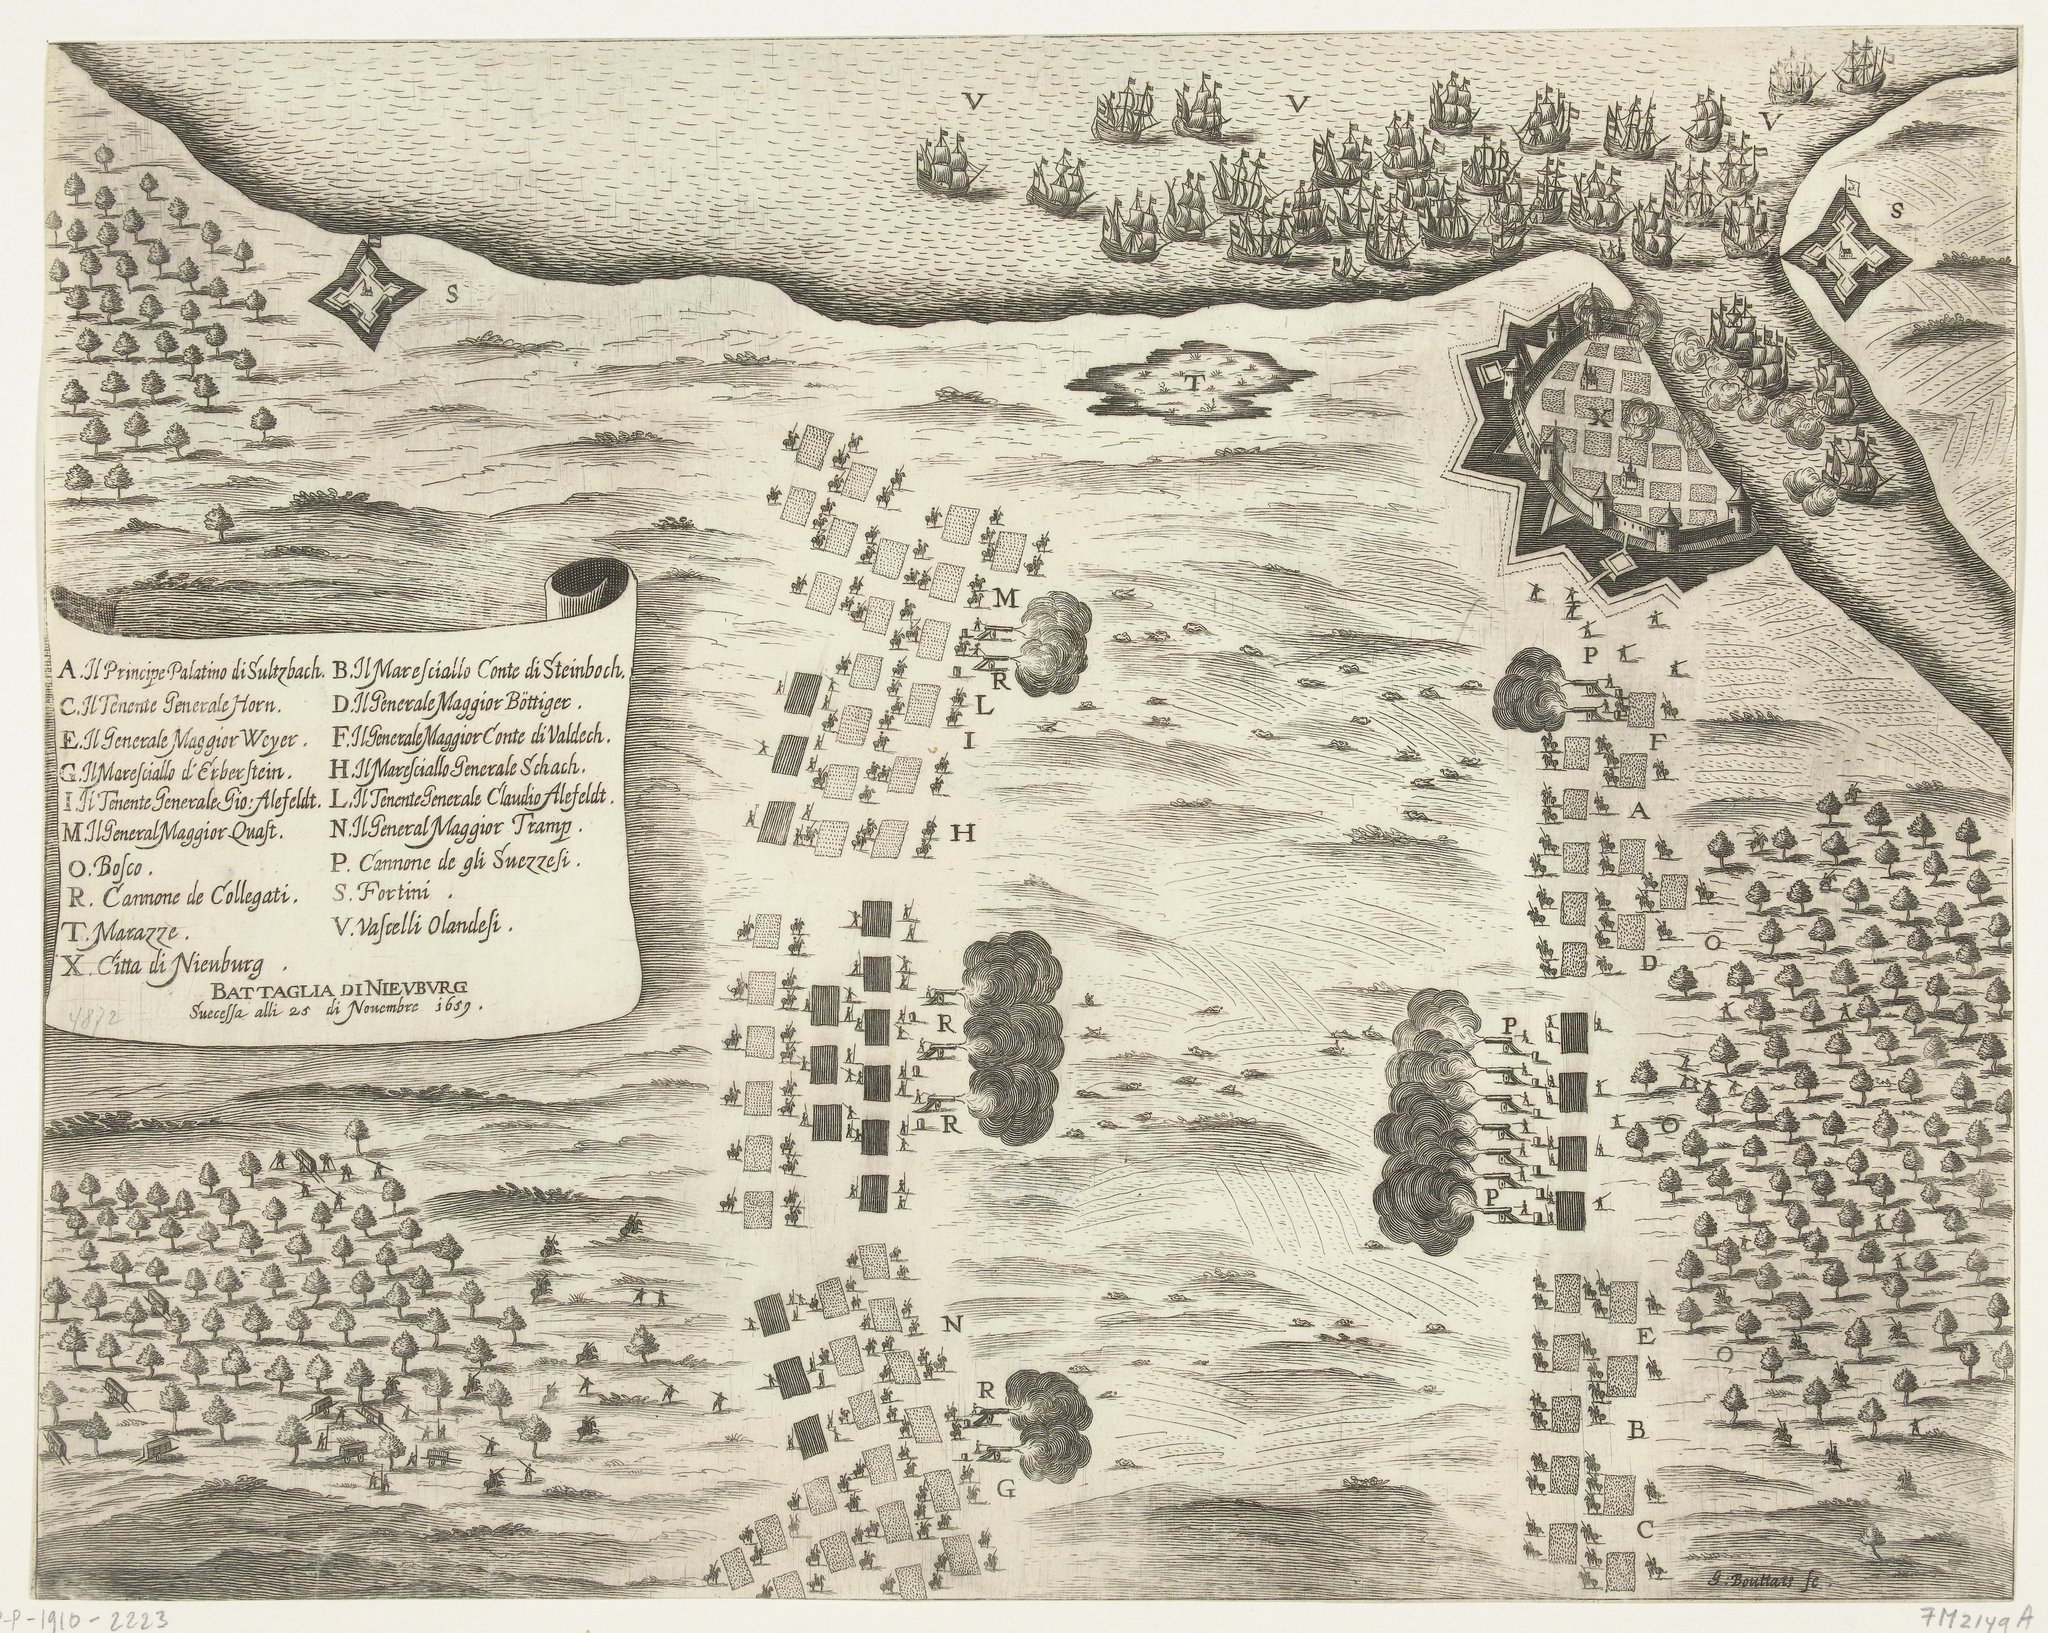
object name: map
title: Veldslag bij Nyborg, 1659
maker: gaspar bouttats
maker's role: print maker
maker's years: 1640-1695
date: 1659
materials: paper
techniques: engraving, etching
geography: southern netherlands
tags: flushing, michiel adriaenszoon de ruyter, battle (+ land forces)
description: Kaart met de inname van de stad Nyborg door Michiel Adriaenszoon de Ruyter en het verslaan van het Zweedse leger door de Denen, 25 november 1659. In het midden beschieten de Denen en de Zweden elkaar op het open veld, rechtsboven de Hollandse vloot bij de stad Nyborg. Links een banderol met de legenda A-X in het Italiaans.